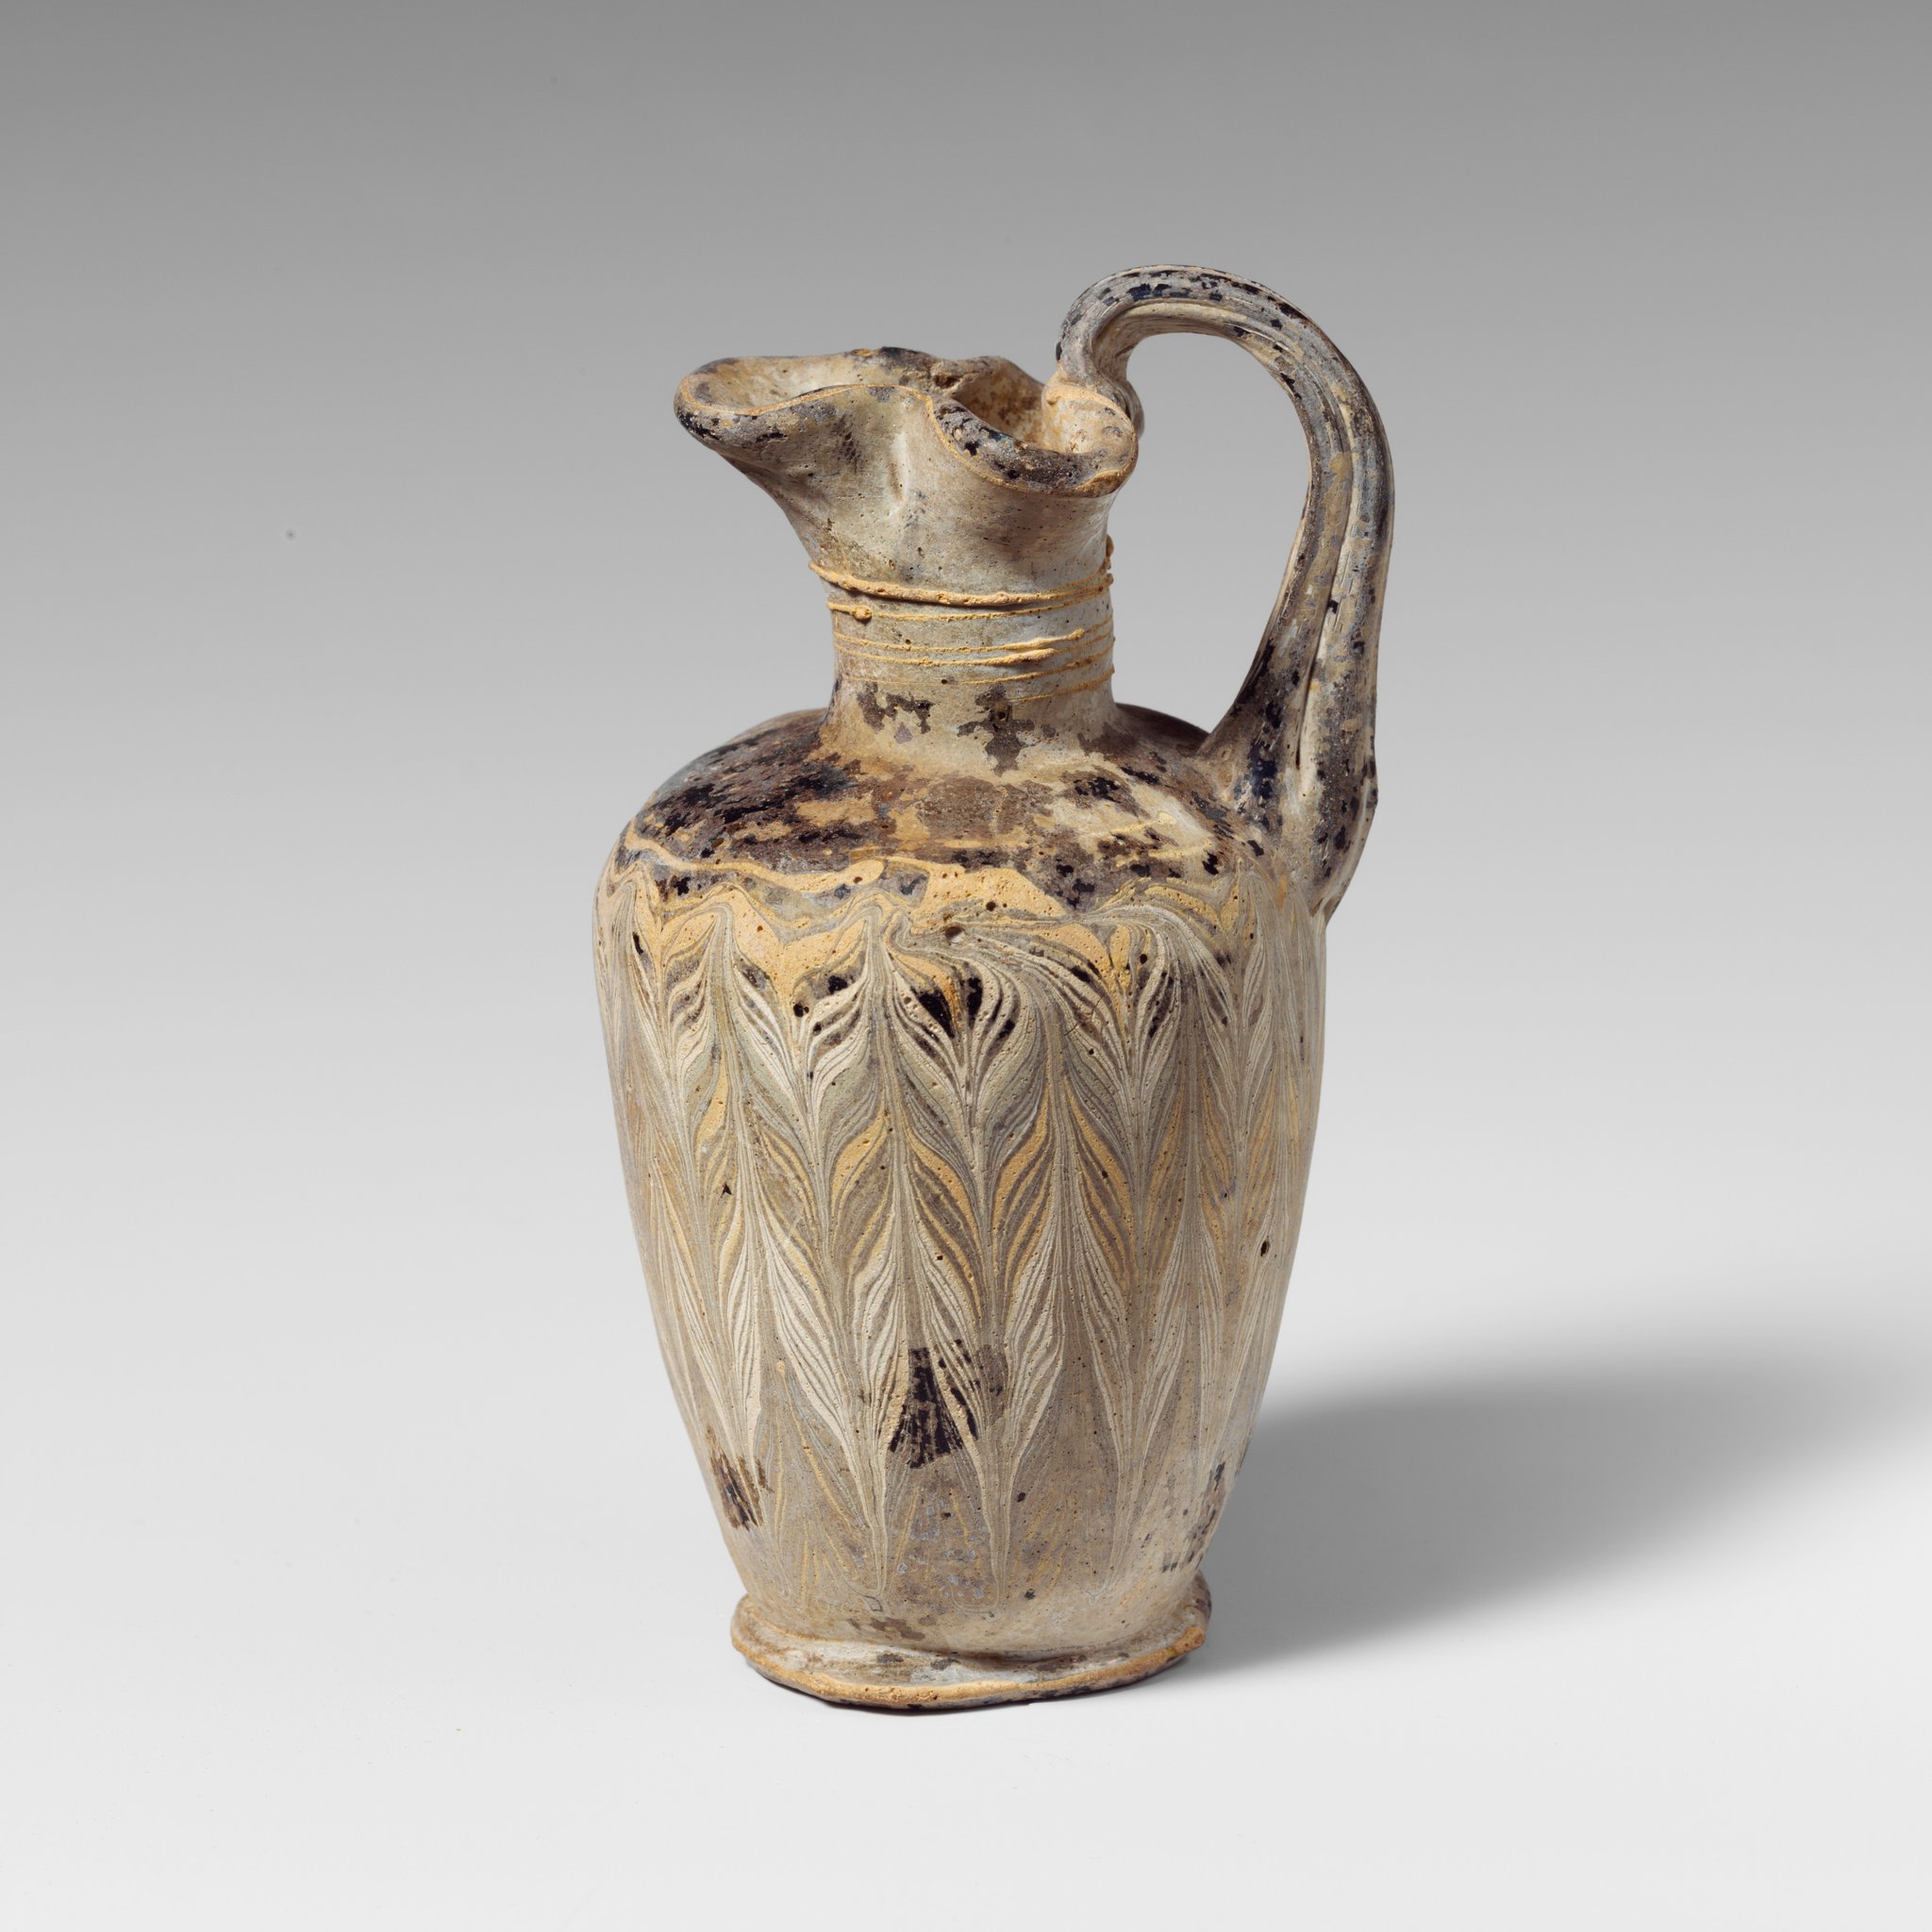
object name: oinochoe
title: Glass oinochoe (perfume jug)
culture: greek or eastern mediterranean or italian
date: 367-268 BCE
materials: glass